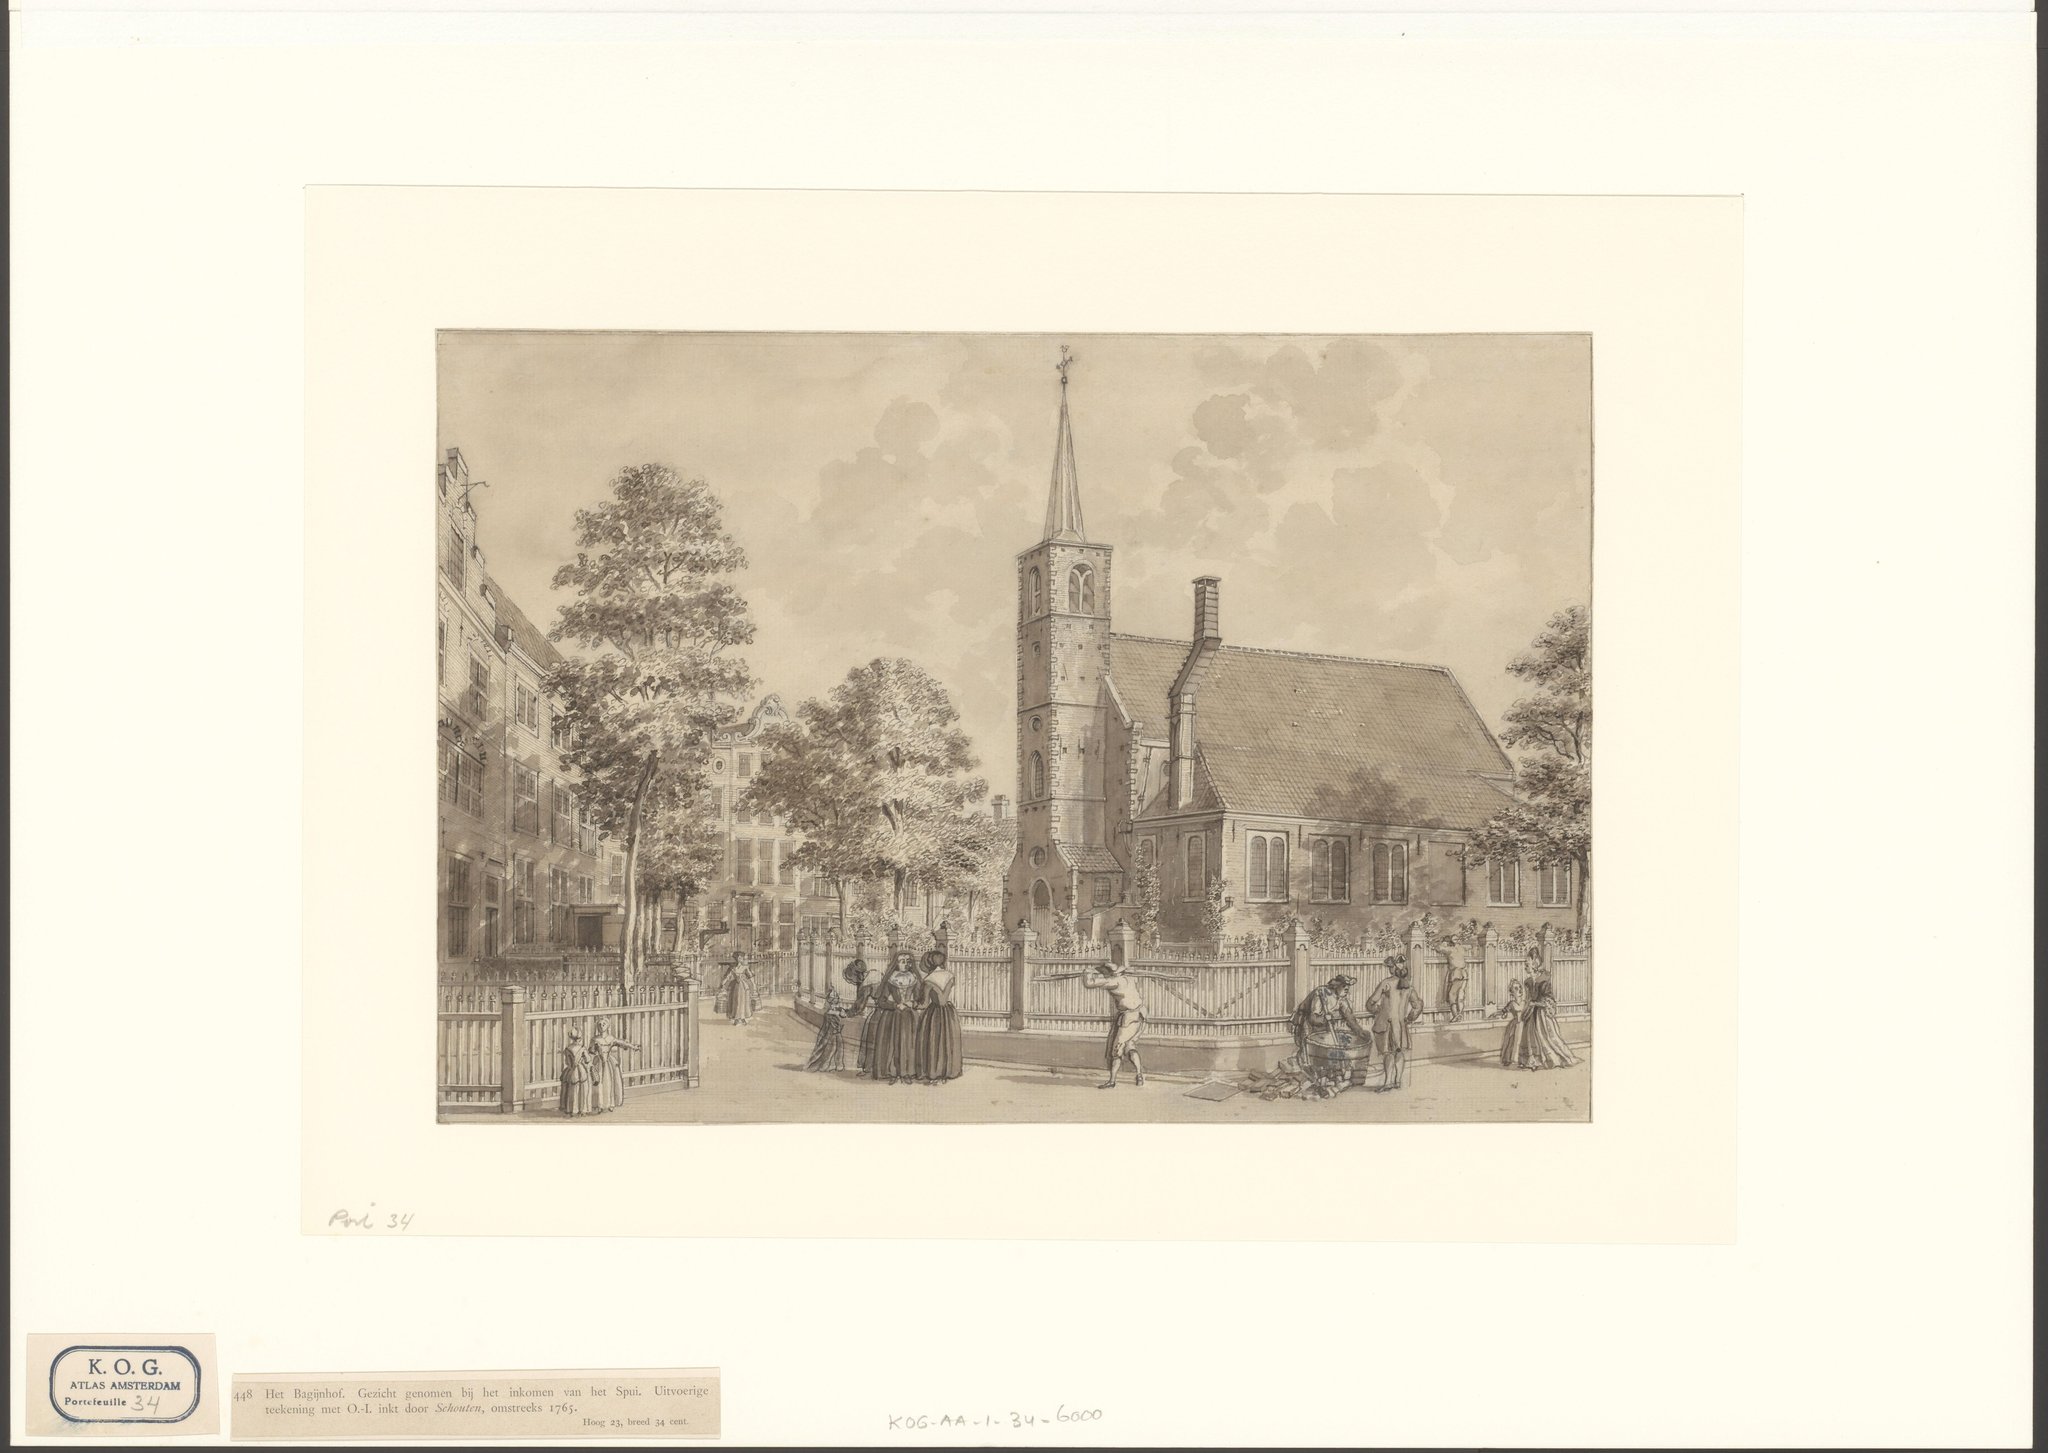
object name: drawing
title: Gezicht op het Begijnhof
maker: hermanus petrus schouten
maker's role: draughtsman, painter, print maker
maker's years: 1747-1822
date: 1757-1822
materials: paint, ink, paper, pencil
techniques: brush, pen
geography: amsterdam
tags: alms-house (dutch: 'hofje'), city-view in general; 'veduta'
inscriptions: inscription: ‘448 Het Bagijnhof. (...) breed 34 cent.’, collector's mark: ‘34’ Lugt 1641b, inscription: ‘Port 34’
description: Onderwerpsrubriek binnen de Atlas Amsterdam: Begijnhof, t/m Petrus en Paulus.